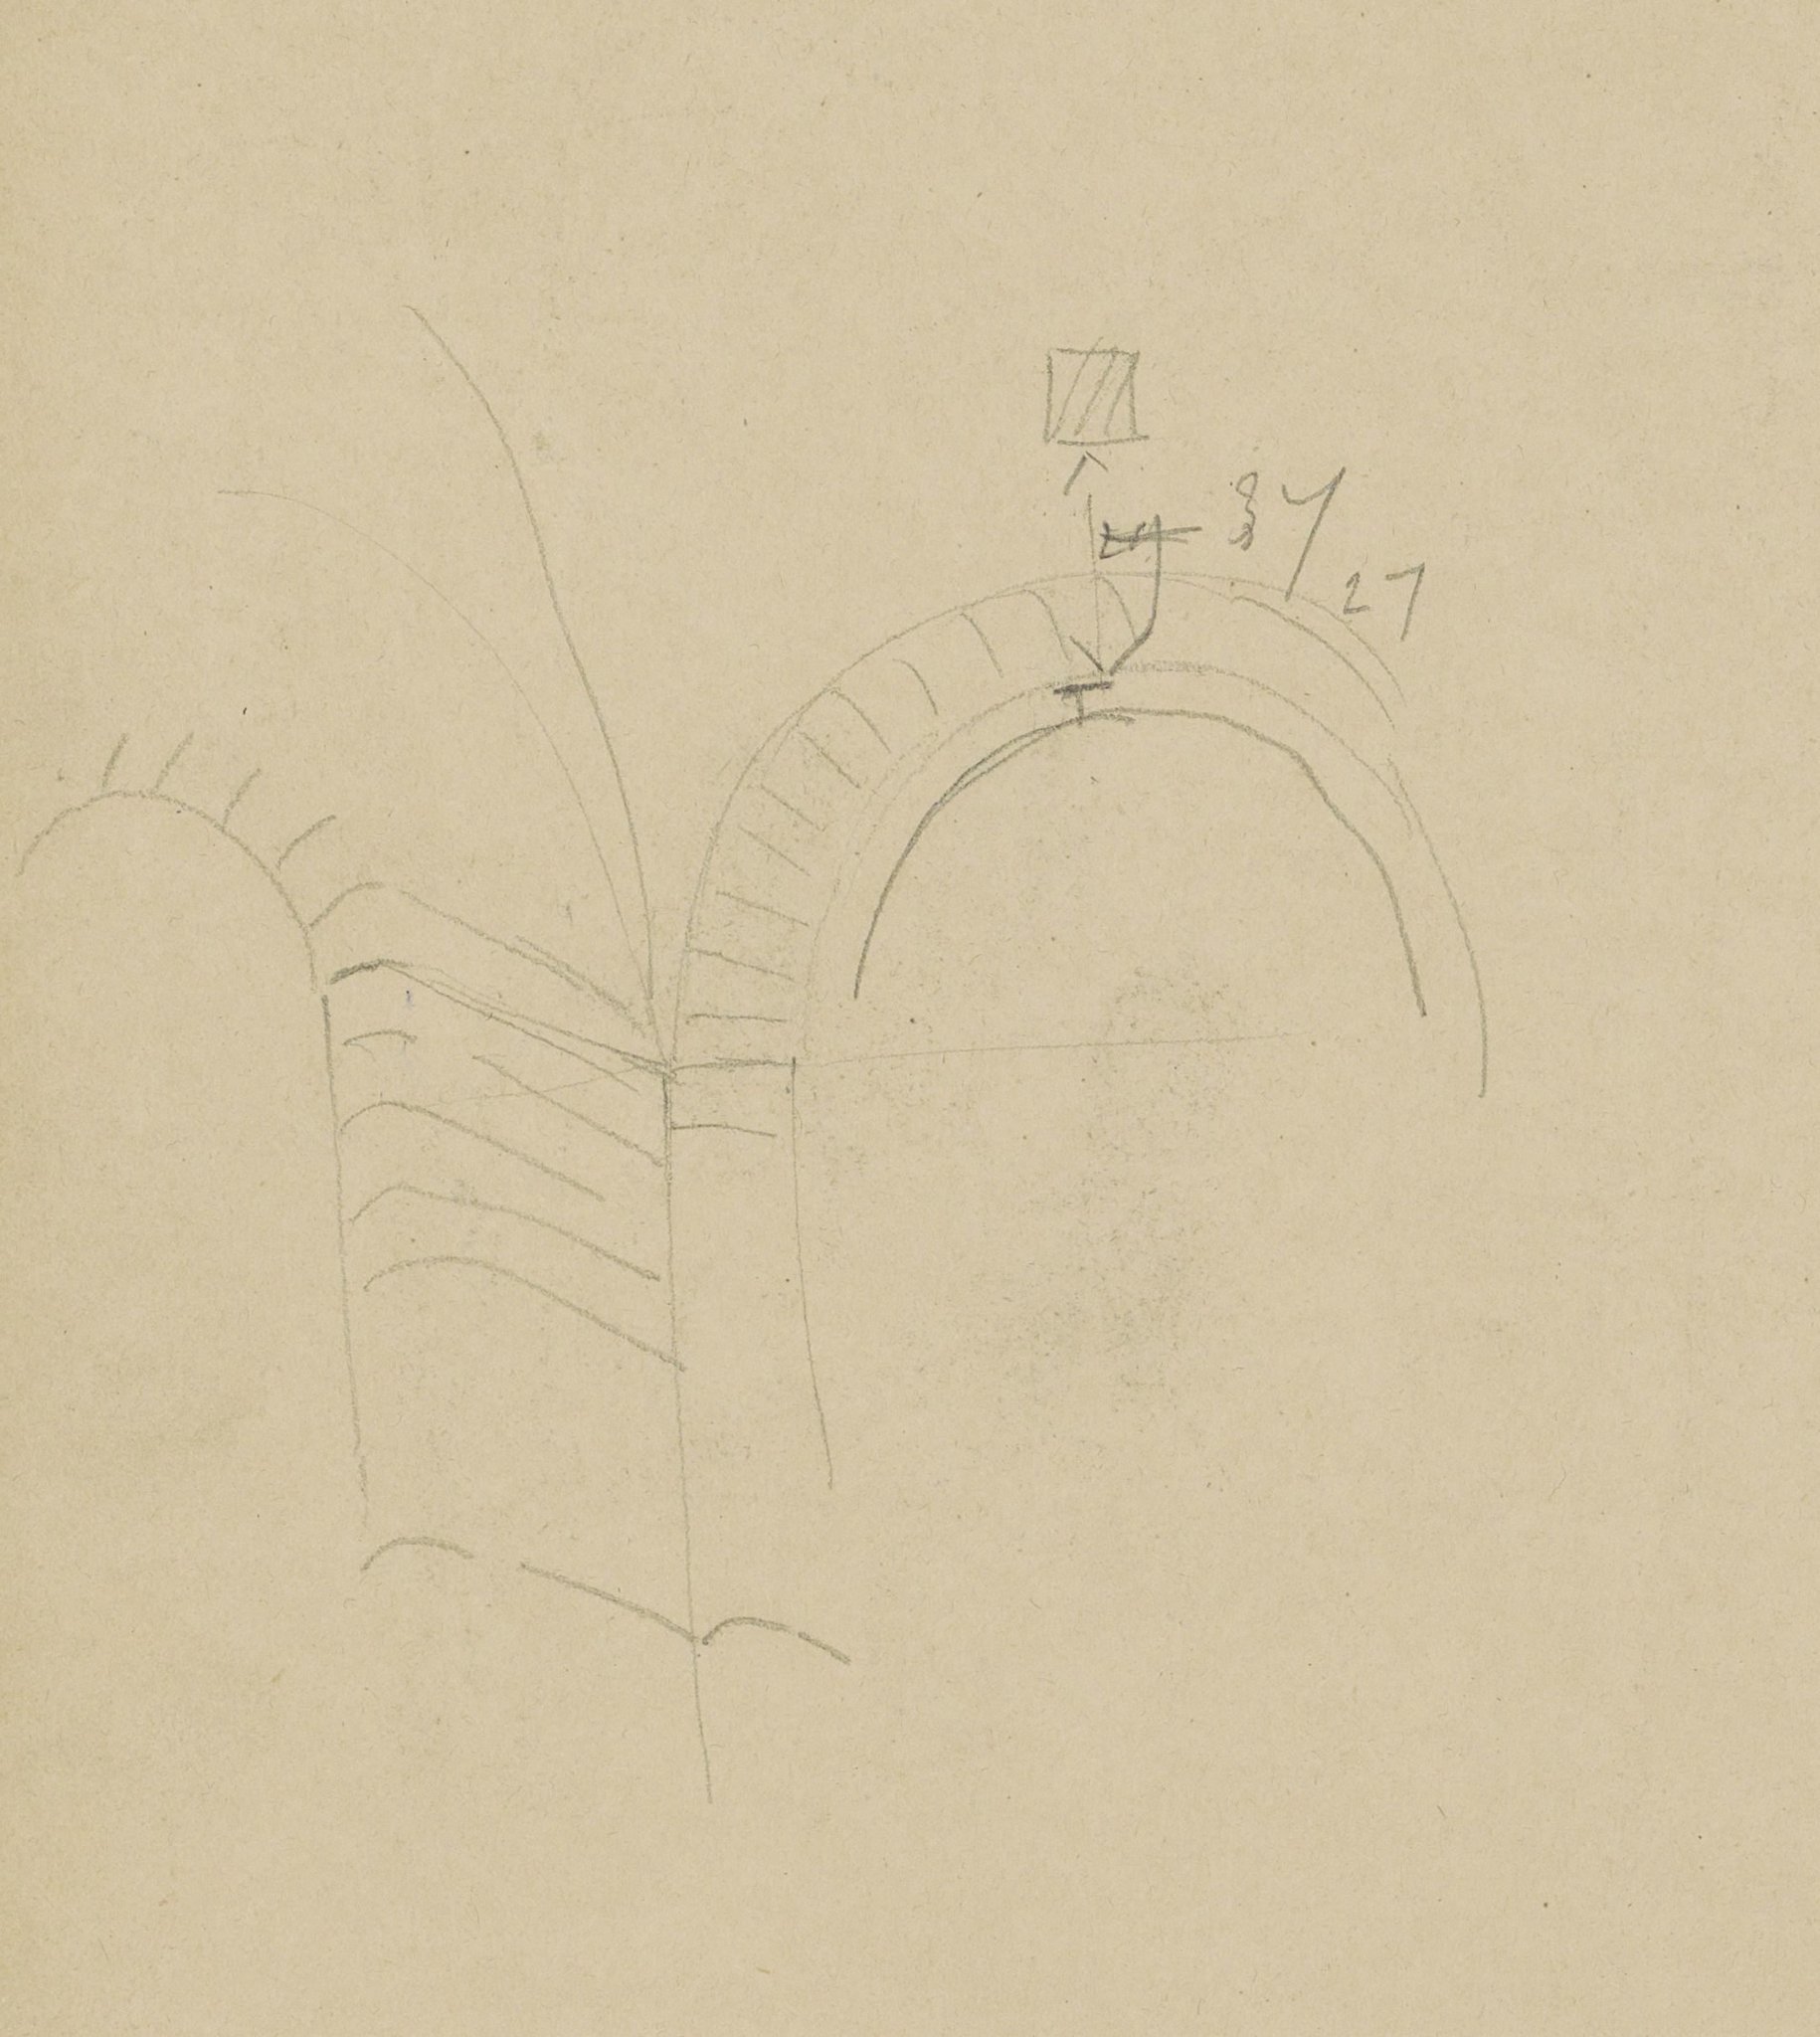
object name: sketchbook leaf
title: Twee bogen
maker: carel adolph lion cachet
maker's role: draughtsman, print maker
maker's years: 1864-1945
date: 1905-1906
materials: paper, pencil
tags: arch, archivolt ~ architecture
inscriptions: annotation: ‘37/ 27’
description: Blad 9 verso uit een schetsboek met 30 bladen.